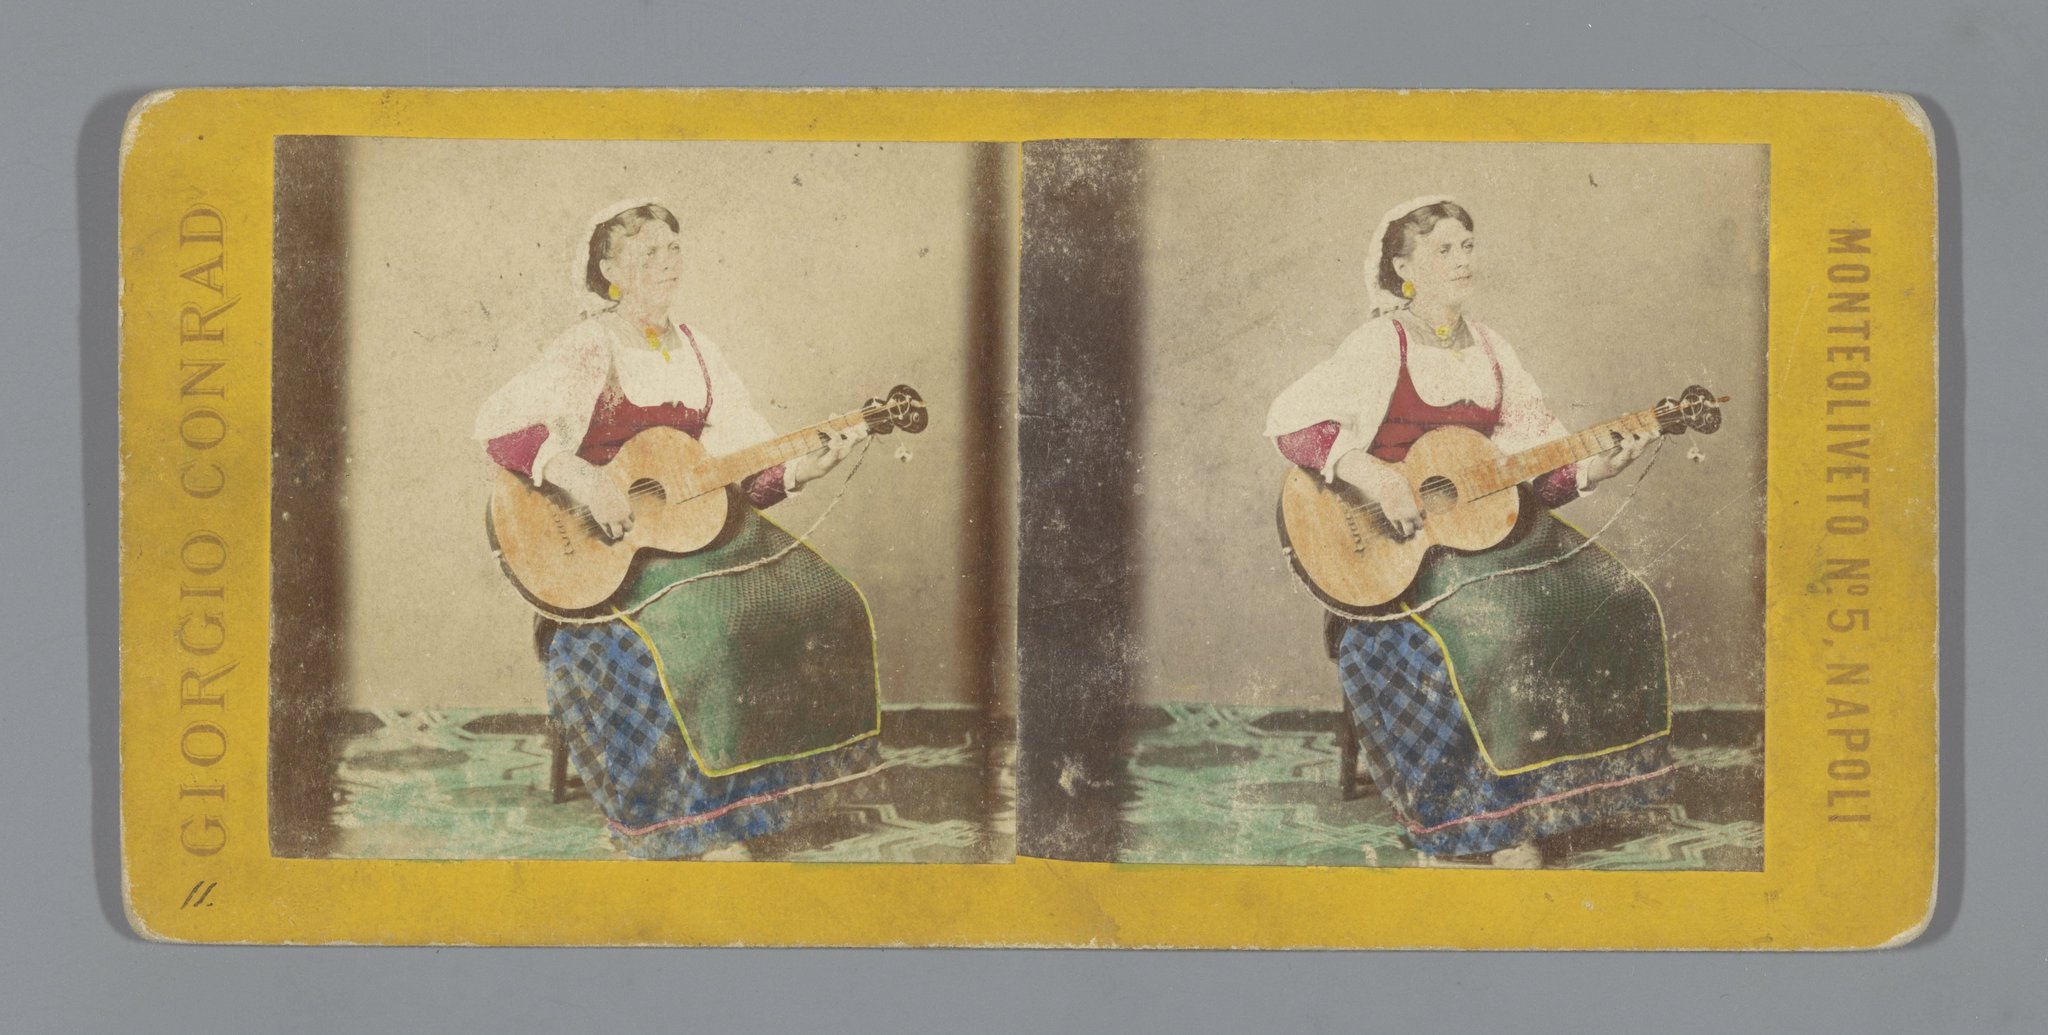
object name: stereograph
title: Portret van een vrouw in klederdracht met een gitaar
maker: giorgio conrad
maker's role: fotograaf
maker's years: 1827-1889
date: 1860-1880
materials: cardboard, paper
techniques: albumen print, hand coloring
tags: adult woman, folk costume, regional costume, cithern, mandolin, guitar, balalaika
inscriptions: address: ‘Monteoliveto No. 5, Napoli’